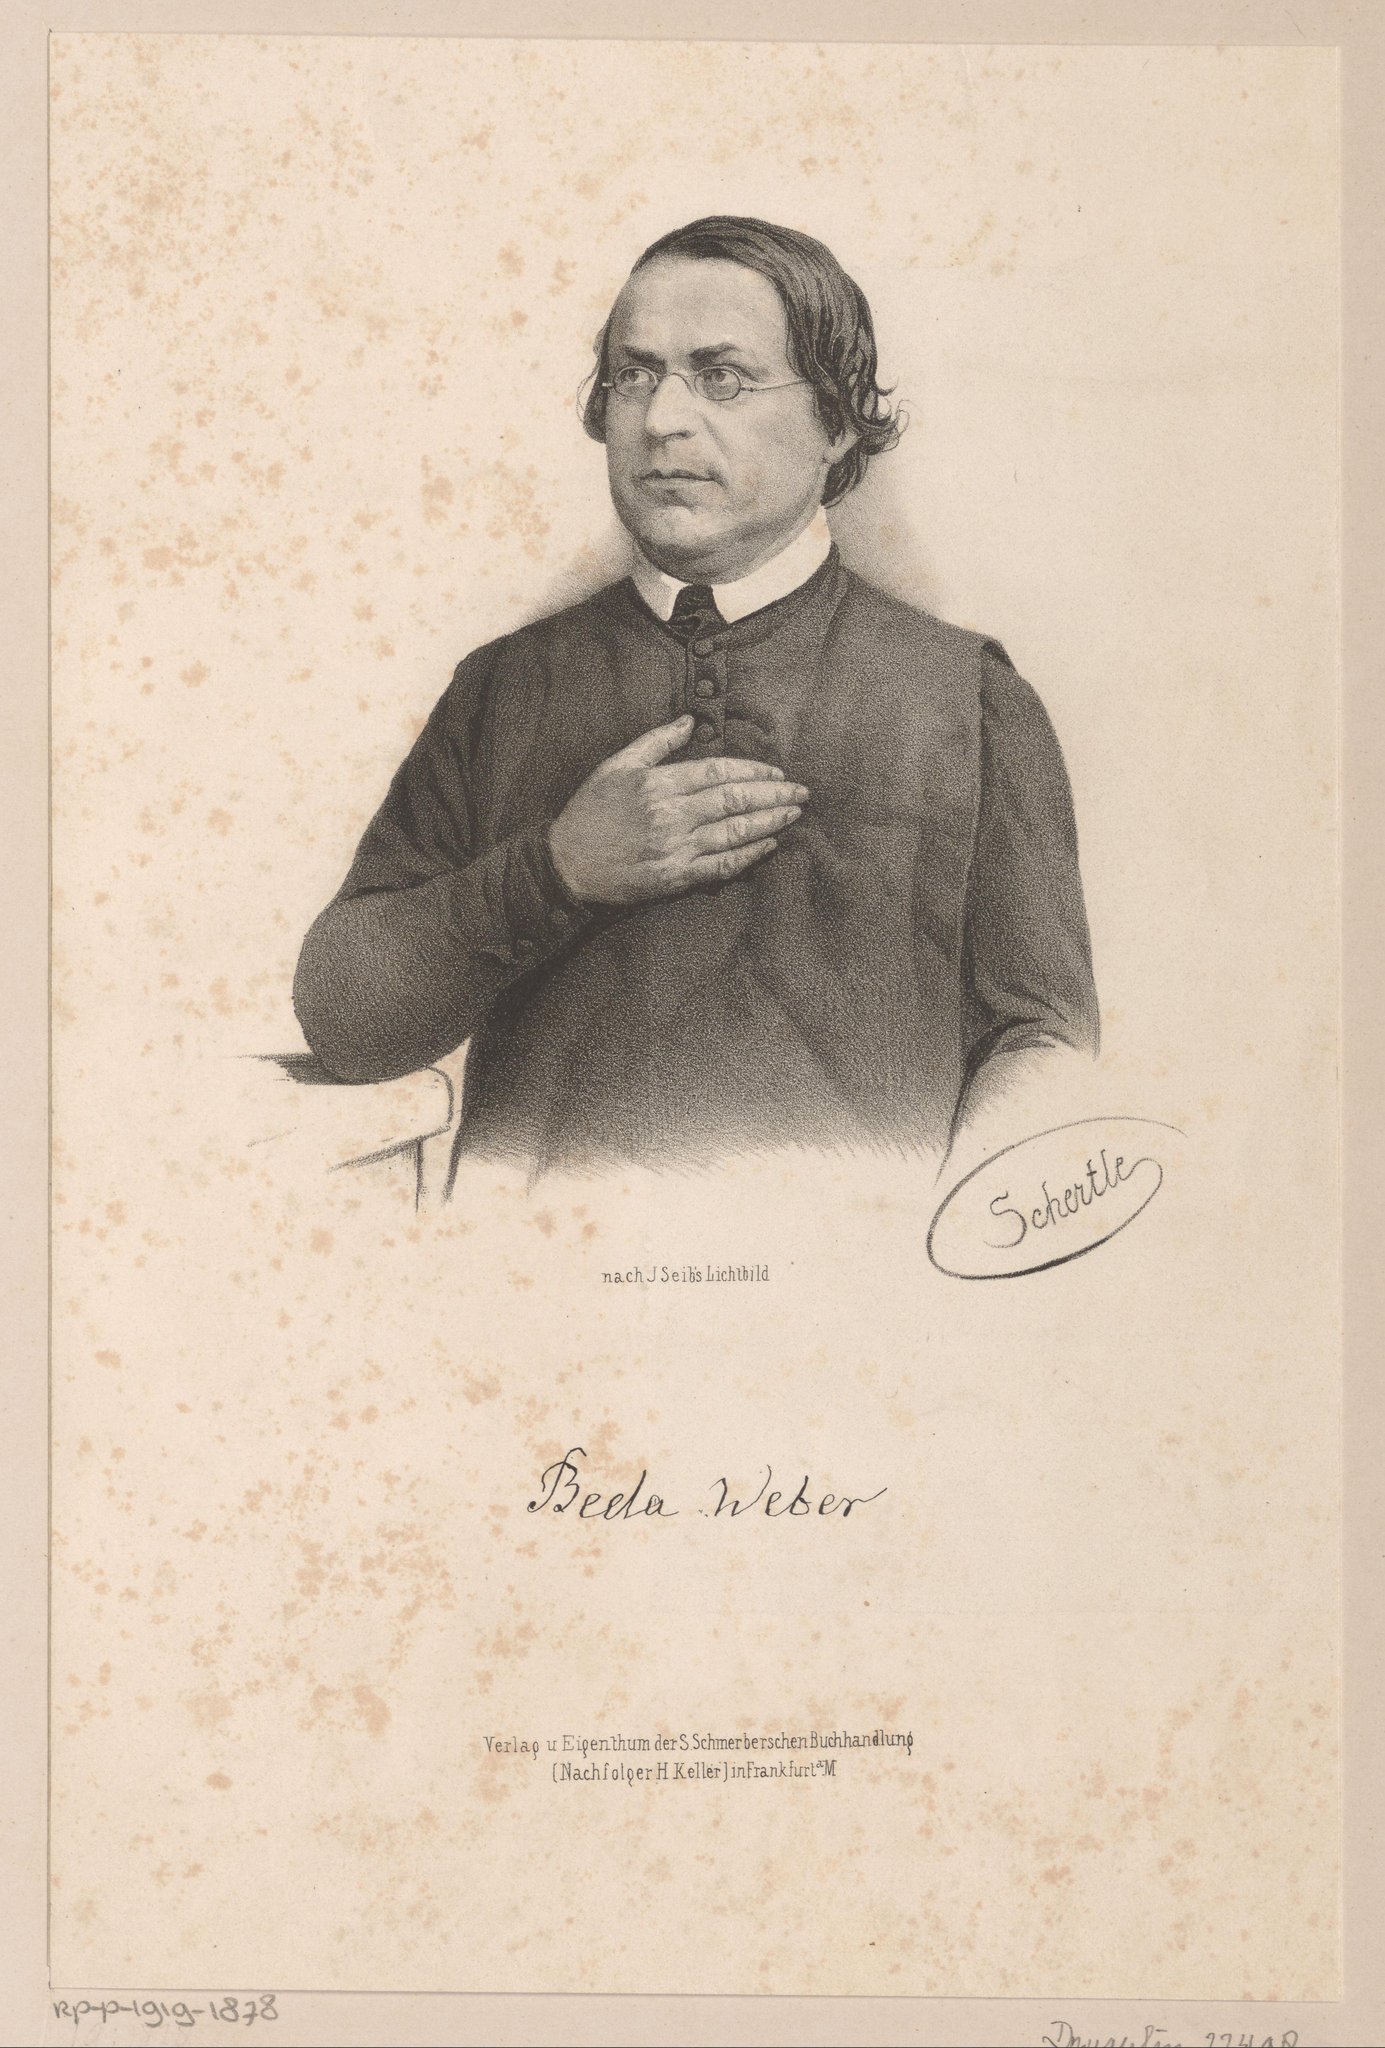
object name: print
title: Portret van Beda Weber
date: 1849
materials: paper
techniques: lithograph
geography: frankfurt am main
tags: theologian, historical persons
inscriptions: collector's mark: Lugt 2228